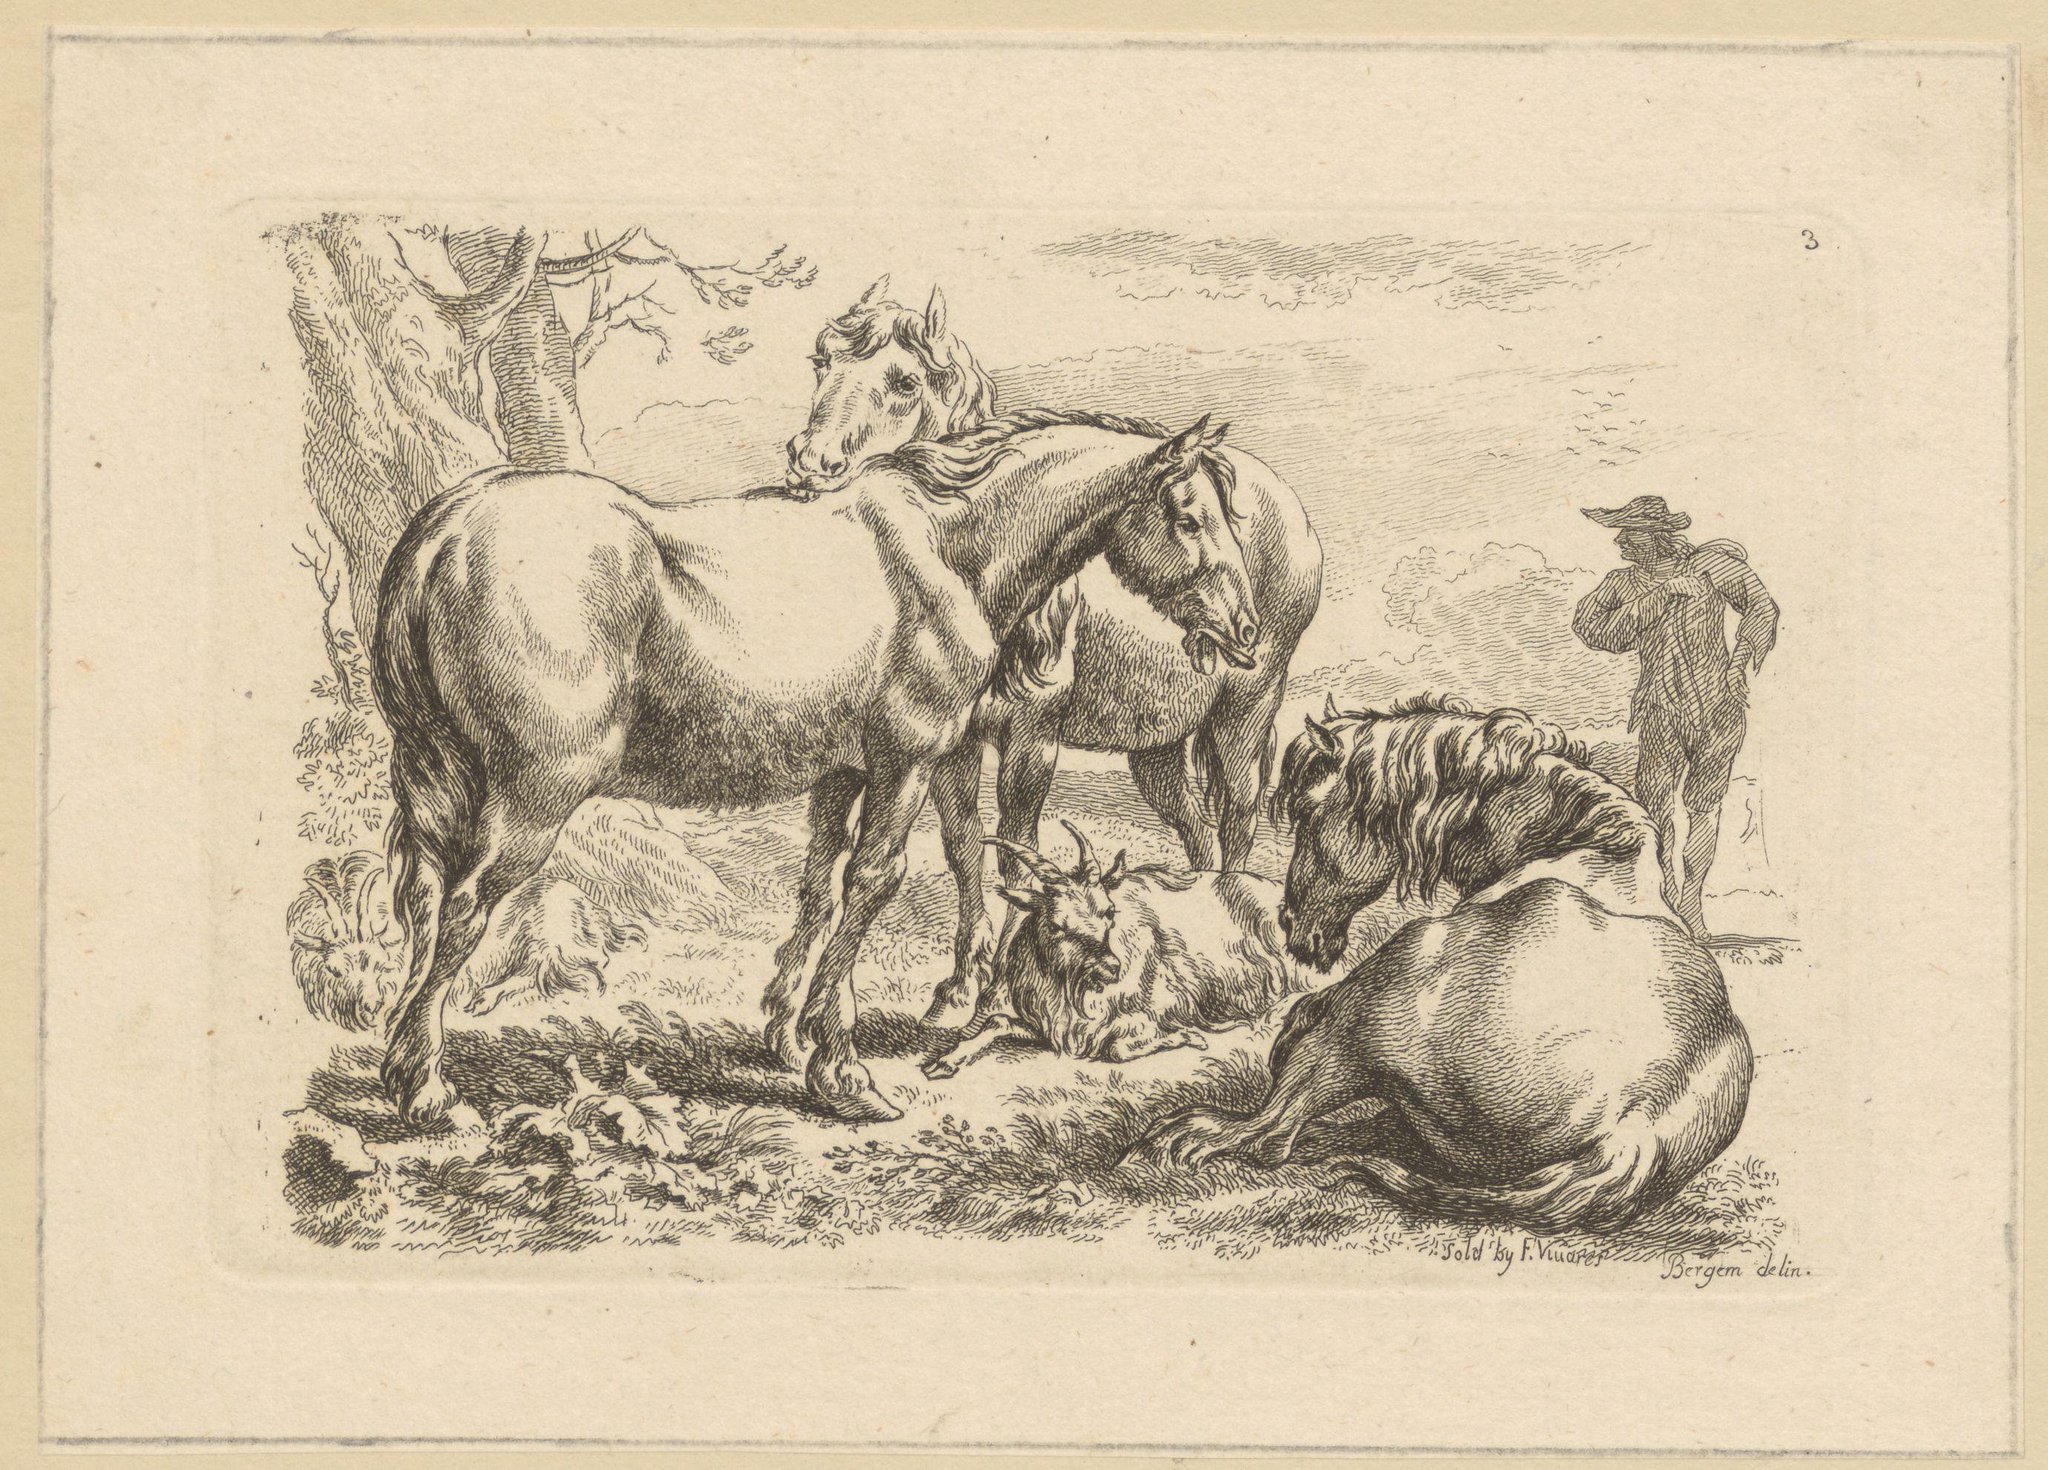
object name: print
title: Drie paarden een geit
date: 1719-1780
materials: paper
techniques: etching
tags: herding, herdsman, herdswoman, shepherd, shepherdess, cowherd, etc., horse, goat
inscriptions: collector's mark: Lugt 240